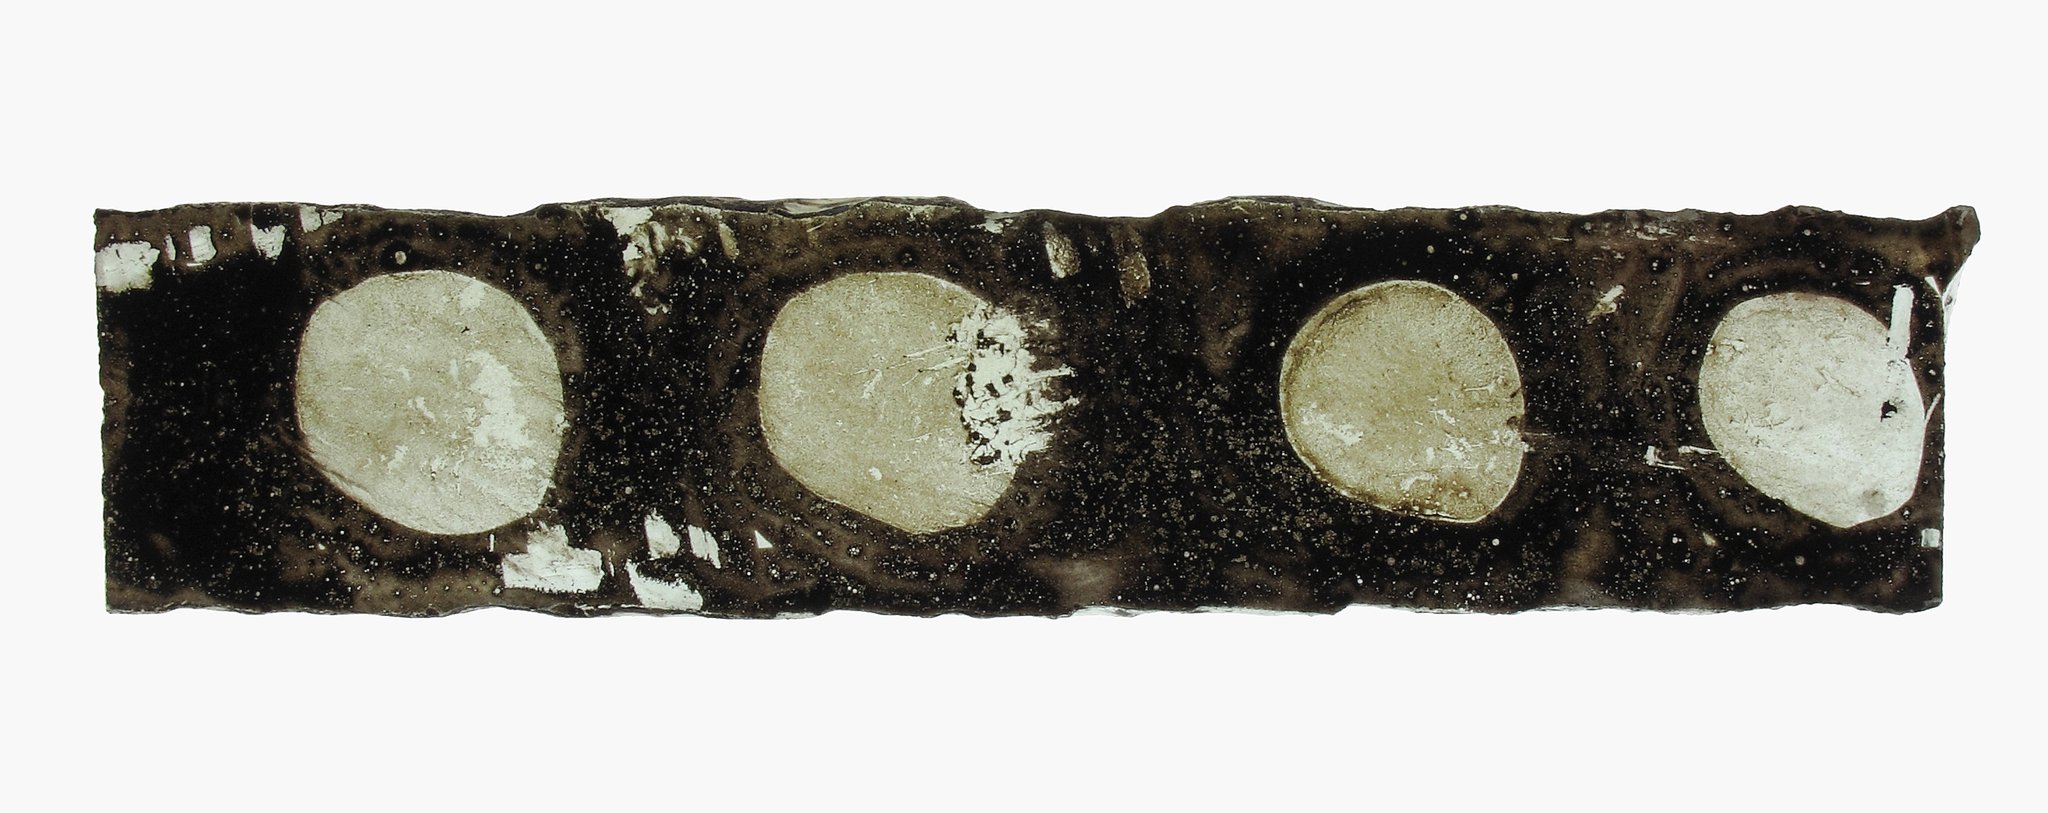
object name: fragment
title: Glass Fragment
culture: european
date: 1301-1500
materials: glass